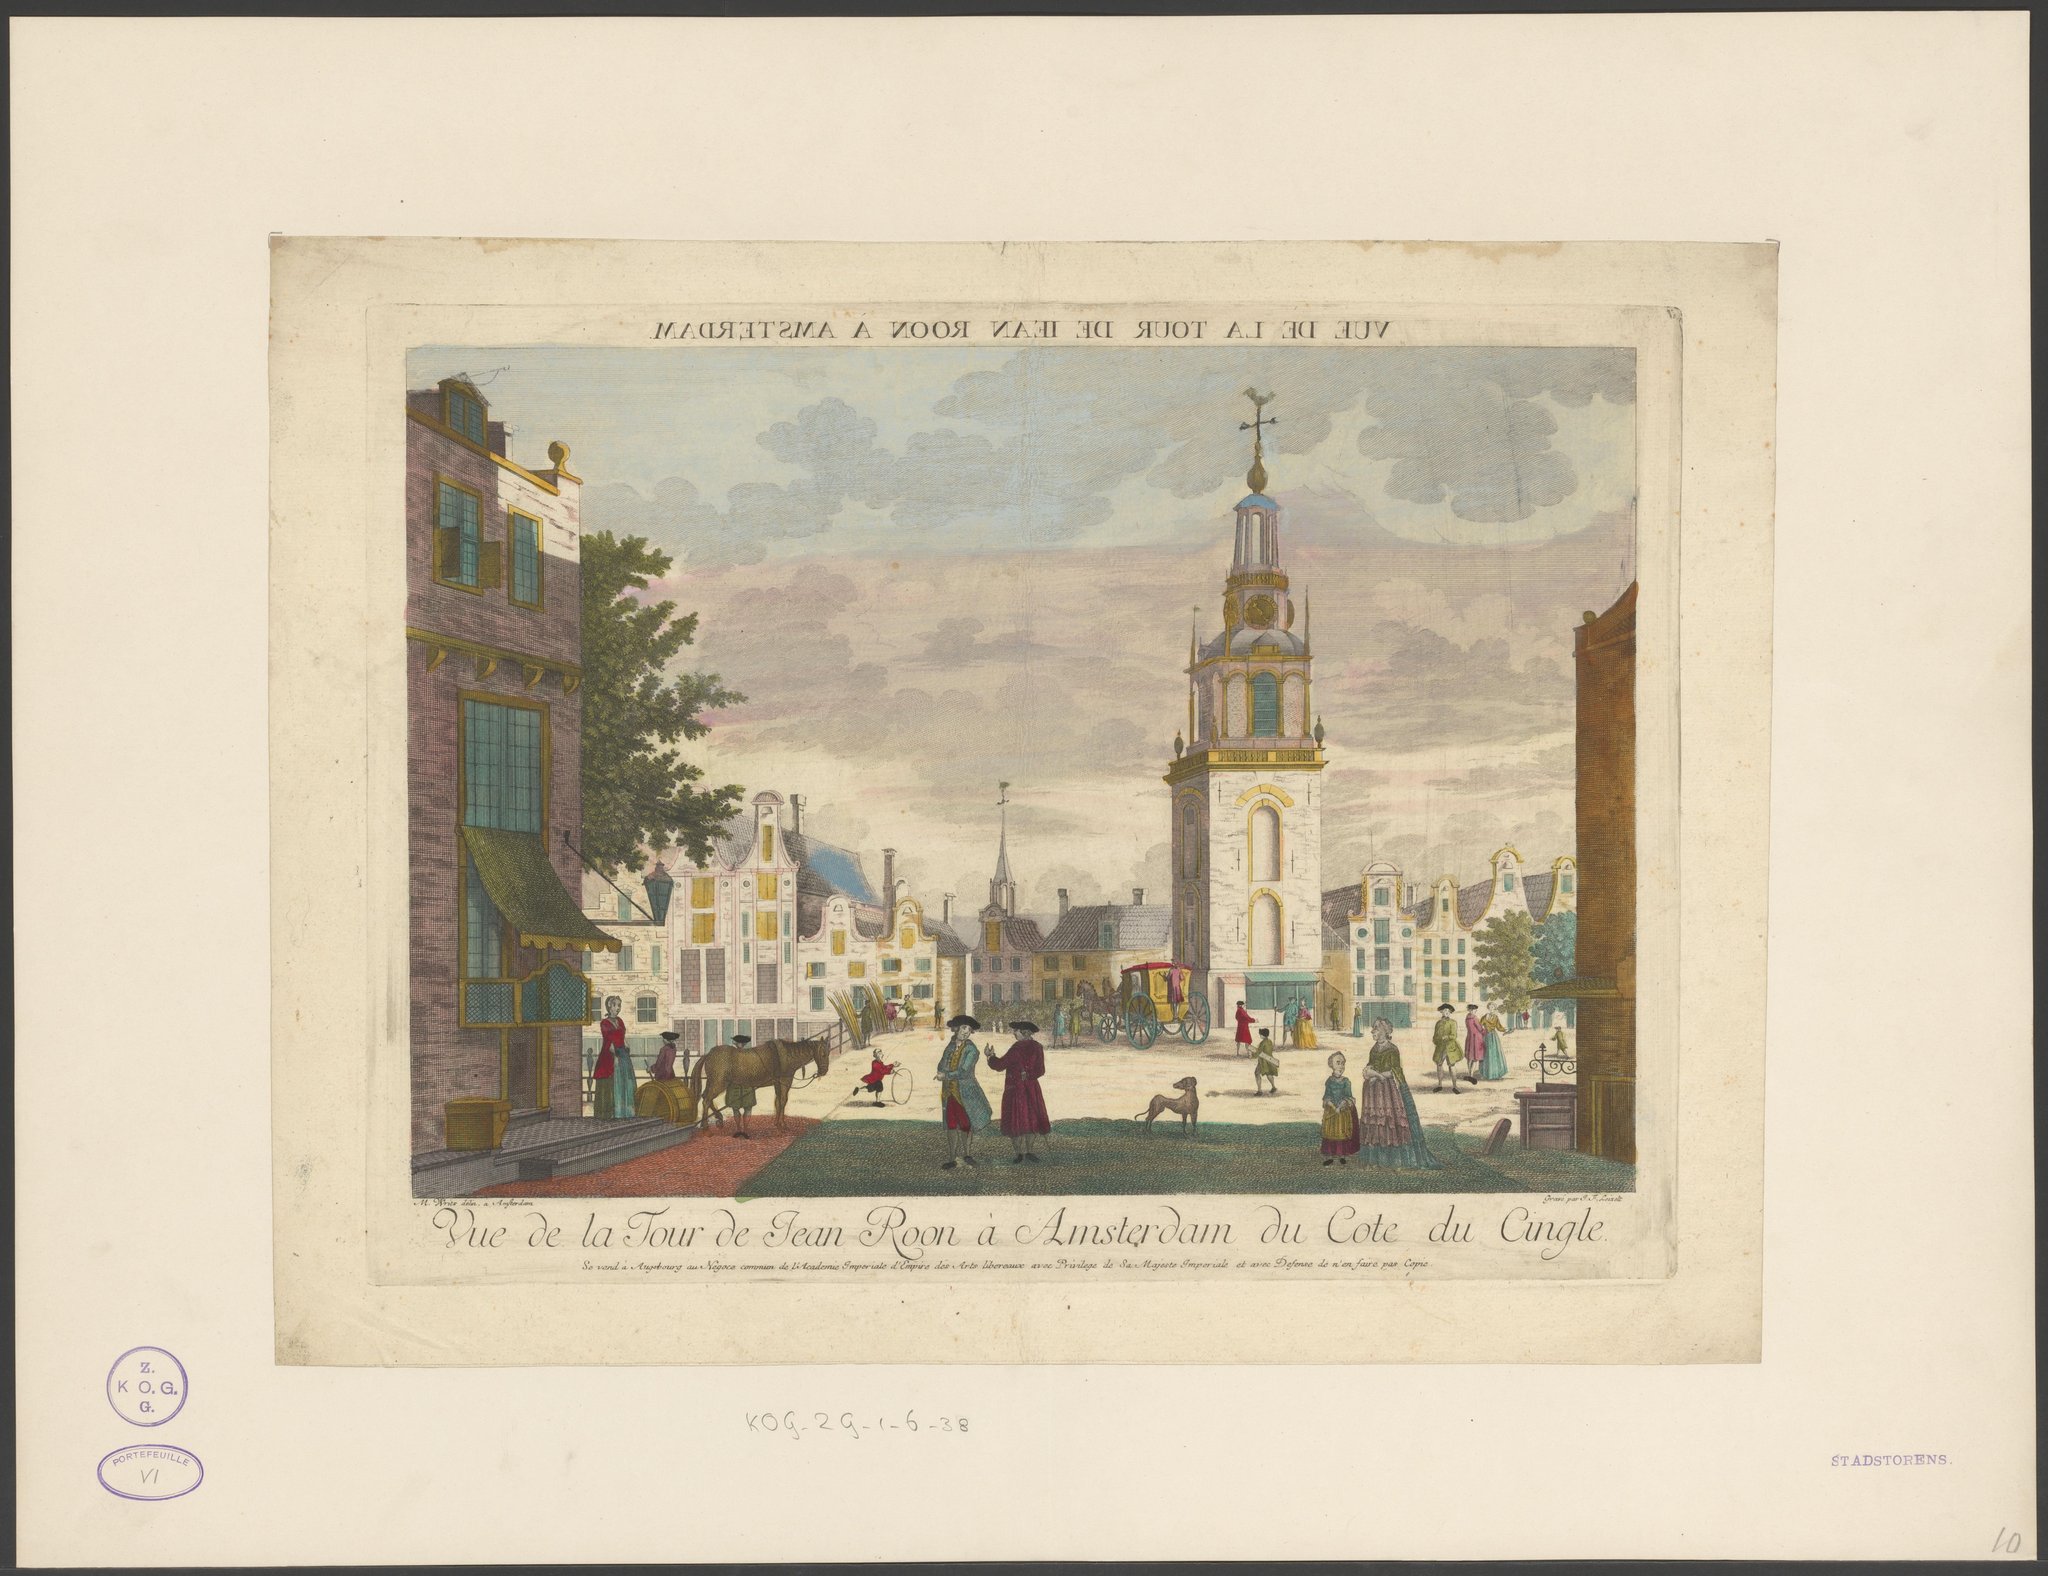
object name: print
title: Vue de la Tour de Jean Roon à Amsterdam du Cote du Cingle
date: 1755-1779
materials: paper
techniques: engraving, etching, hand coloring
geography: augsburg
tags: harbour, city-view in general; 'veduta', towers ~ fortified city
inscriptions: collector's mark: Lugt 1641, stamp, stamp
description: Onderwerpsrubrieken binnen de Atlas Zeden en Gewoonten: Krijgswezen, Stadstorens.